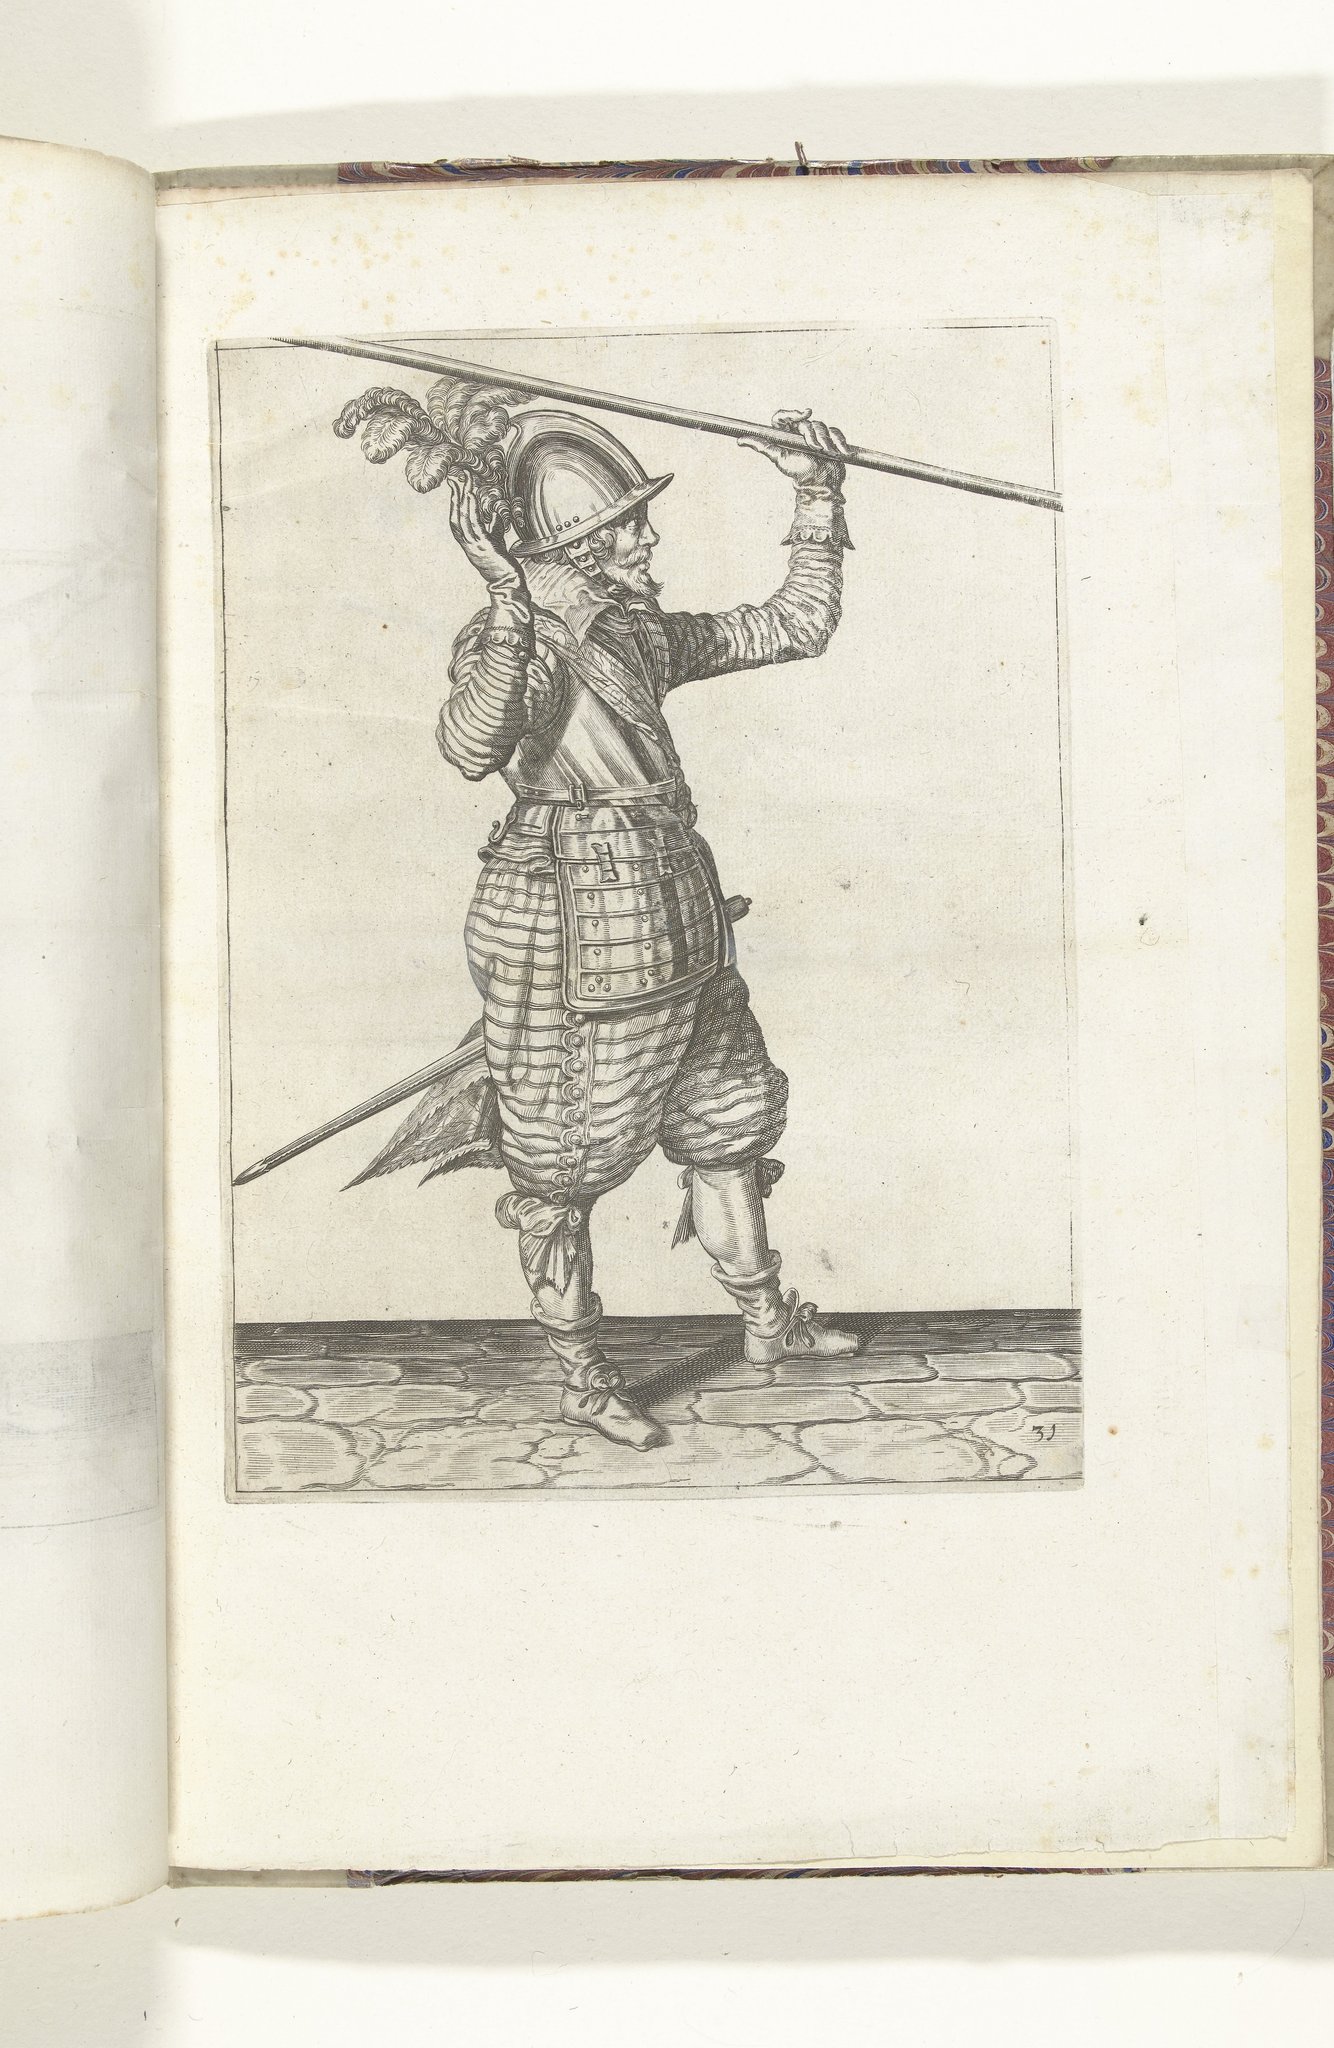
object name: print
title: Soldaat die zijn spies met zijn linkerhand boven zijn linkerschouder tilt, zijn rechterhand opgeheven om hem over te nemen (nr. 31), ca. 1600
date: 1597-1607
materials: paper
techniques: engraving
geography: northern netherlands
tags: the hague, maurice (prince of orange), handling of weapons ~ military training, weapons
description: Een soldaat, ten voeten uit, naar rechts, die een spies (lans) met zijn linkerhand boven zijn linkerschouder tilt, zijn rechterhand opgeheven om hem over te nemen (nr. 31), ca. 1600. Plaat 31 in de instructies voor het hanteren van de spies: Corte onderwysinghe op de figuerliicke afbeeldinghe belanghende trechte gebruck, van alle t'ghene een Soldaet int handelen vande Spies noodich is. Onderdeel van de illustraties in: J. de Gheyn, Wapenhandelinghe van Roers Musquetten ende spiessen, Amsterdam, 1608. Krijgswezen rond 1600.